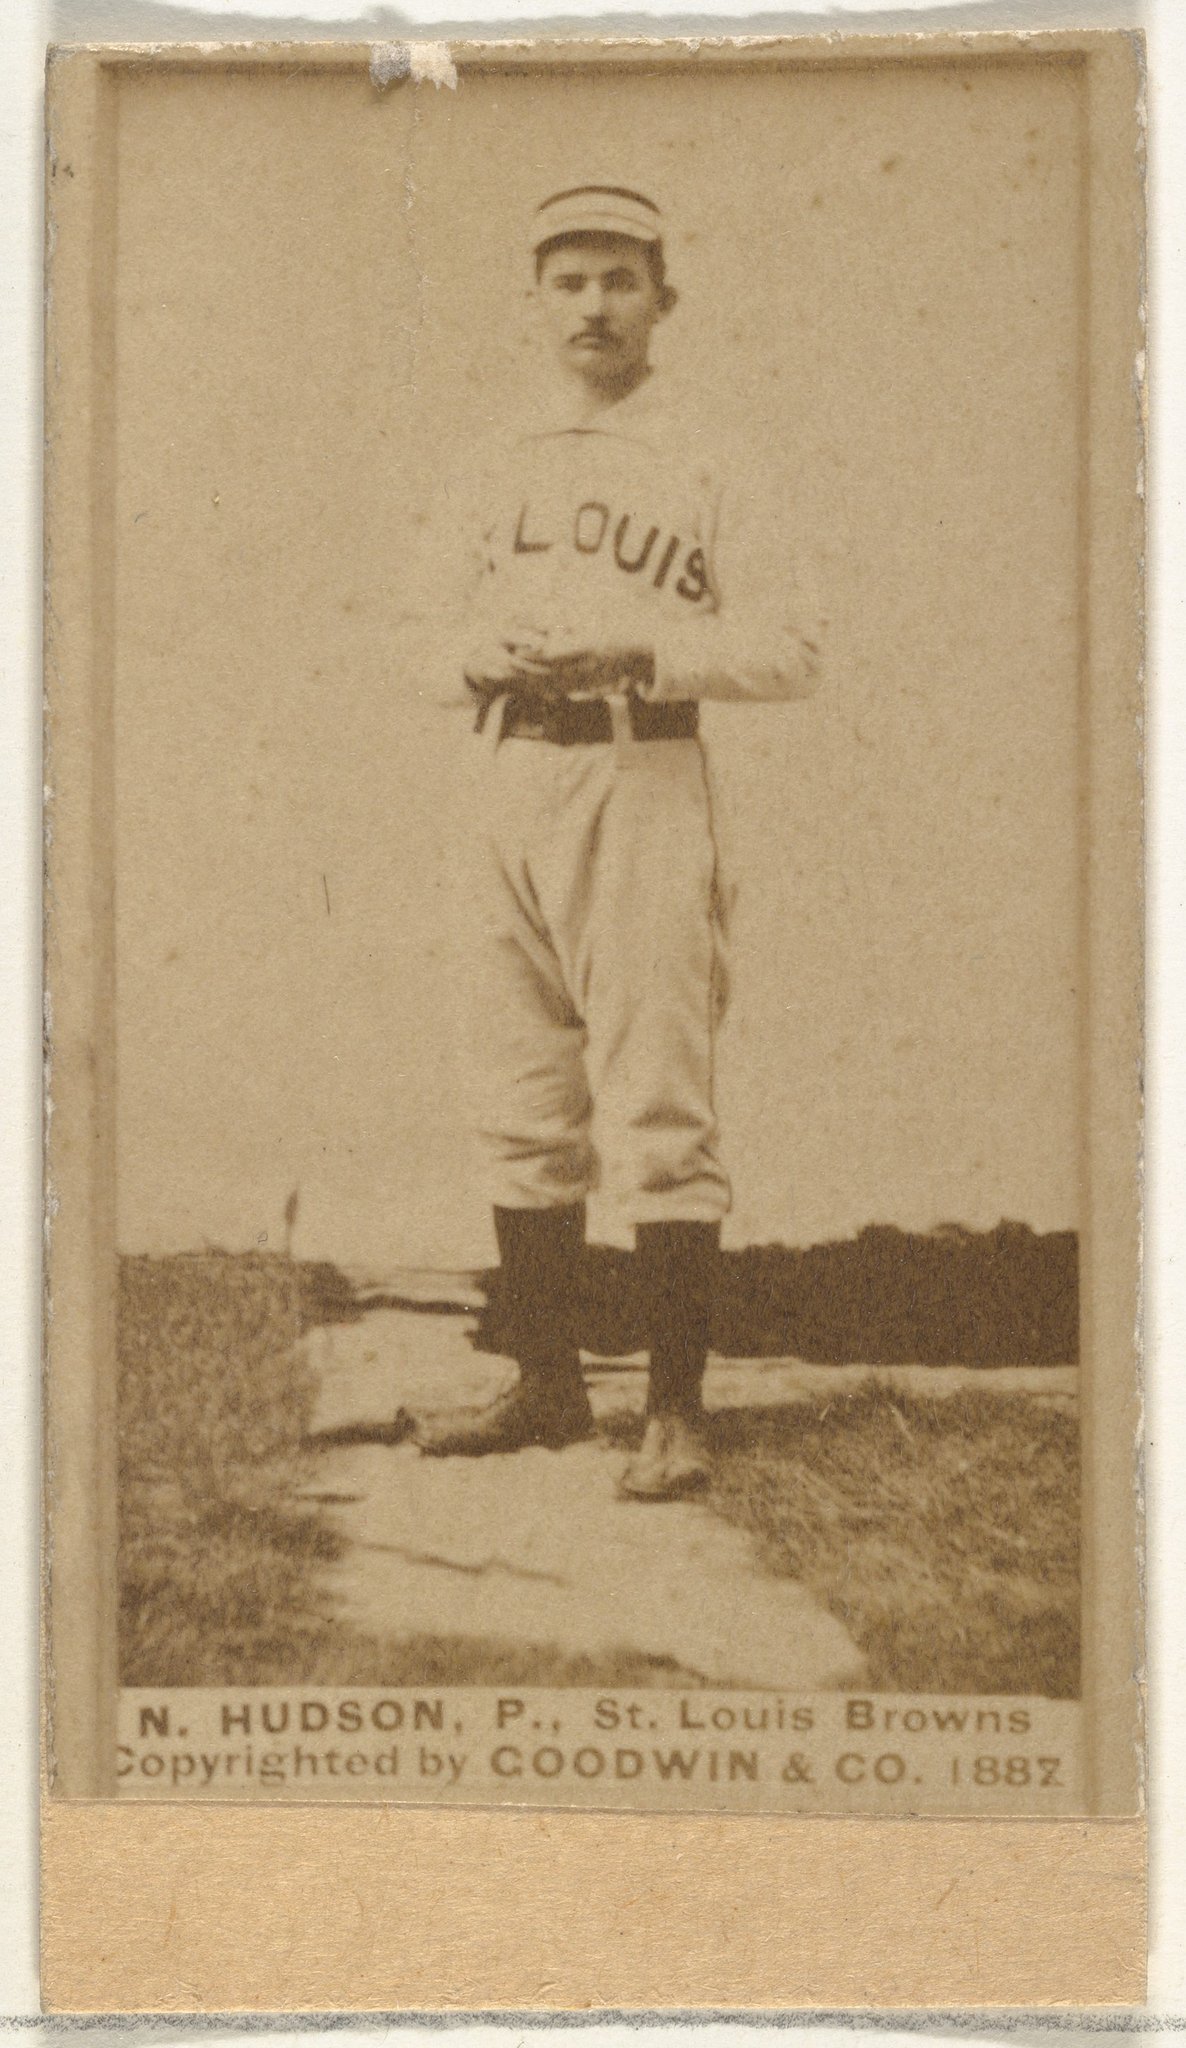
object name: baseball card, photograph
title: Nathaniel P. "Nat" Hudson, Pitcher, St. Louis Browns, from the Old Judge series (N172) for Old Judge Cigarettes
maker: goodwin & company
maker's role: publisher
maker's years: 1850-1950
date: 1888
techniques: albumen silver print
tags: men,portraits,baseball,athletes